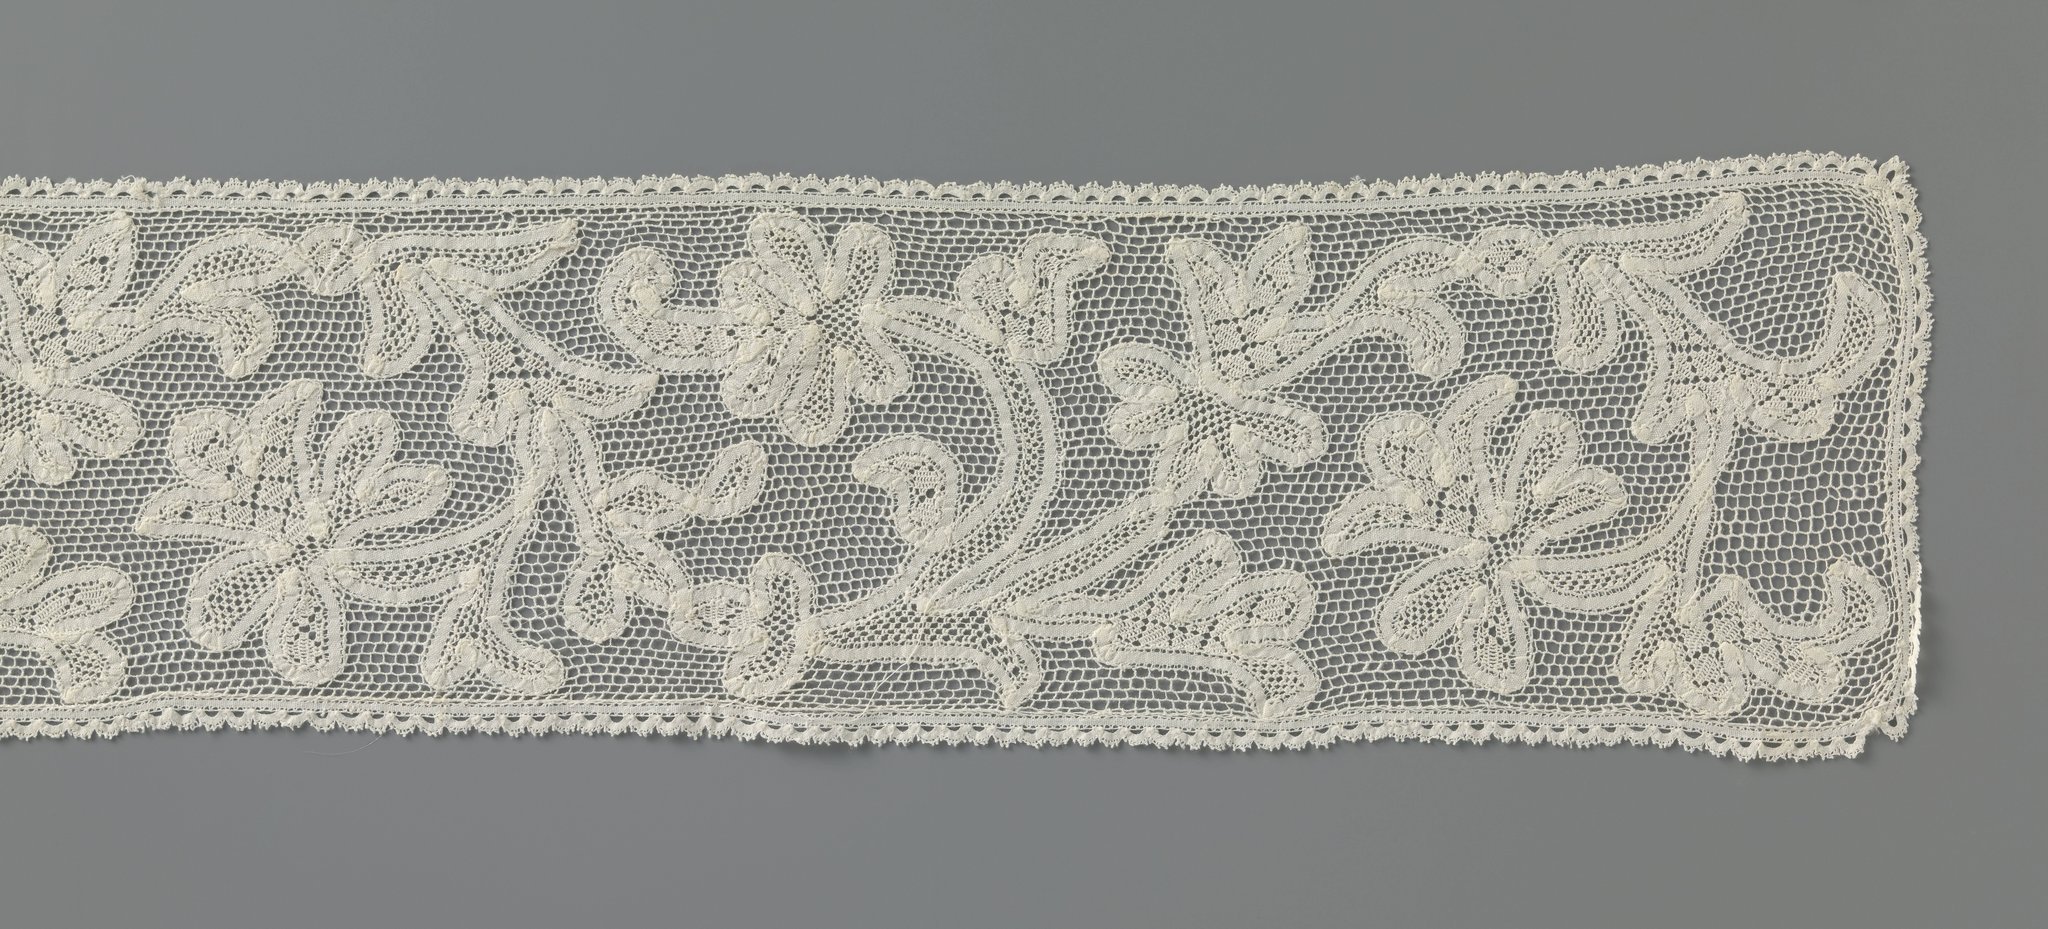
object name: strip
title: Strook gemengde kant met brede spiraalrank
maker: Anonymous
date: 1690-1699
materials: linen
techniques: lace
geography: milan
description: Strook naturelkleurige gemengde kant - mezzo punto - met een geklost of geweven lint en een naaldkantgrond. Op een maasgrond (naaldkant) staat een patroon dat bestaat uit brede omkrullende stengels met exotische bloemen. De contouren van de bloemen en stengels bestaan uit gekloste of geweven linten. Binnen de contouren zijn verschillende siergronden (naaldkant) toegepast. Een geklost boogjesrandje dient als afwerking langs de buitenzijden.